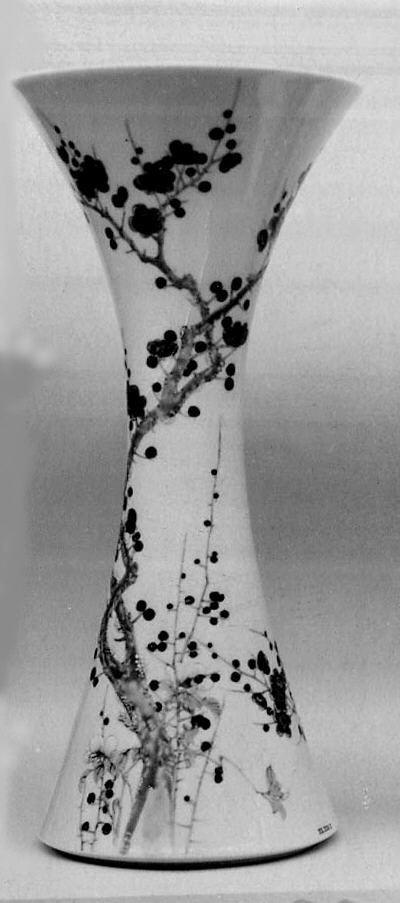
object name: vase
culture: japanese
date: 1860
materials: porcelain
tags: trees